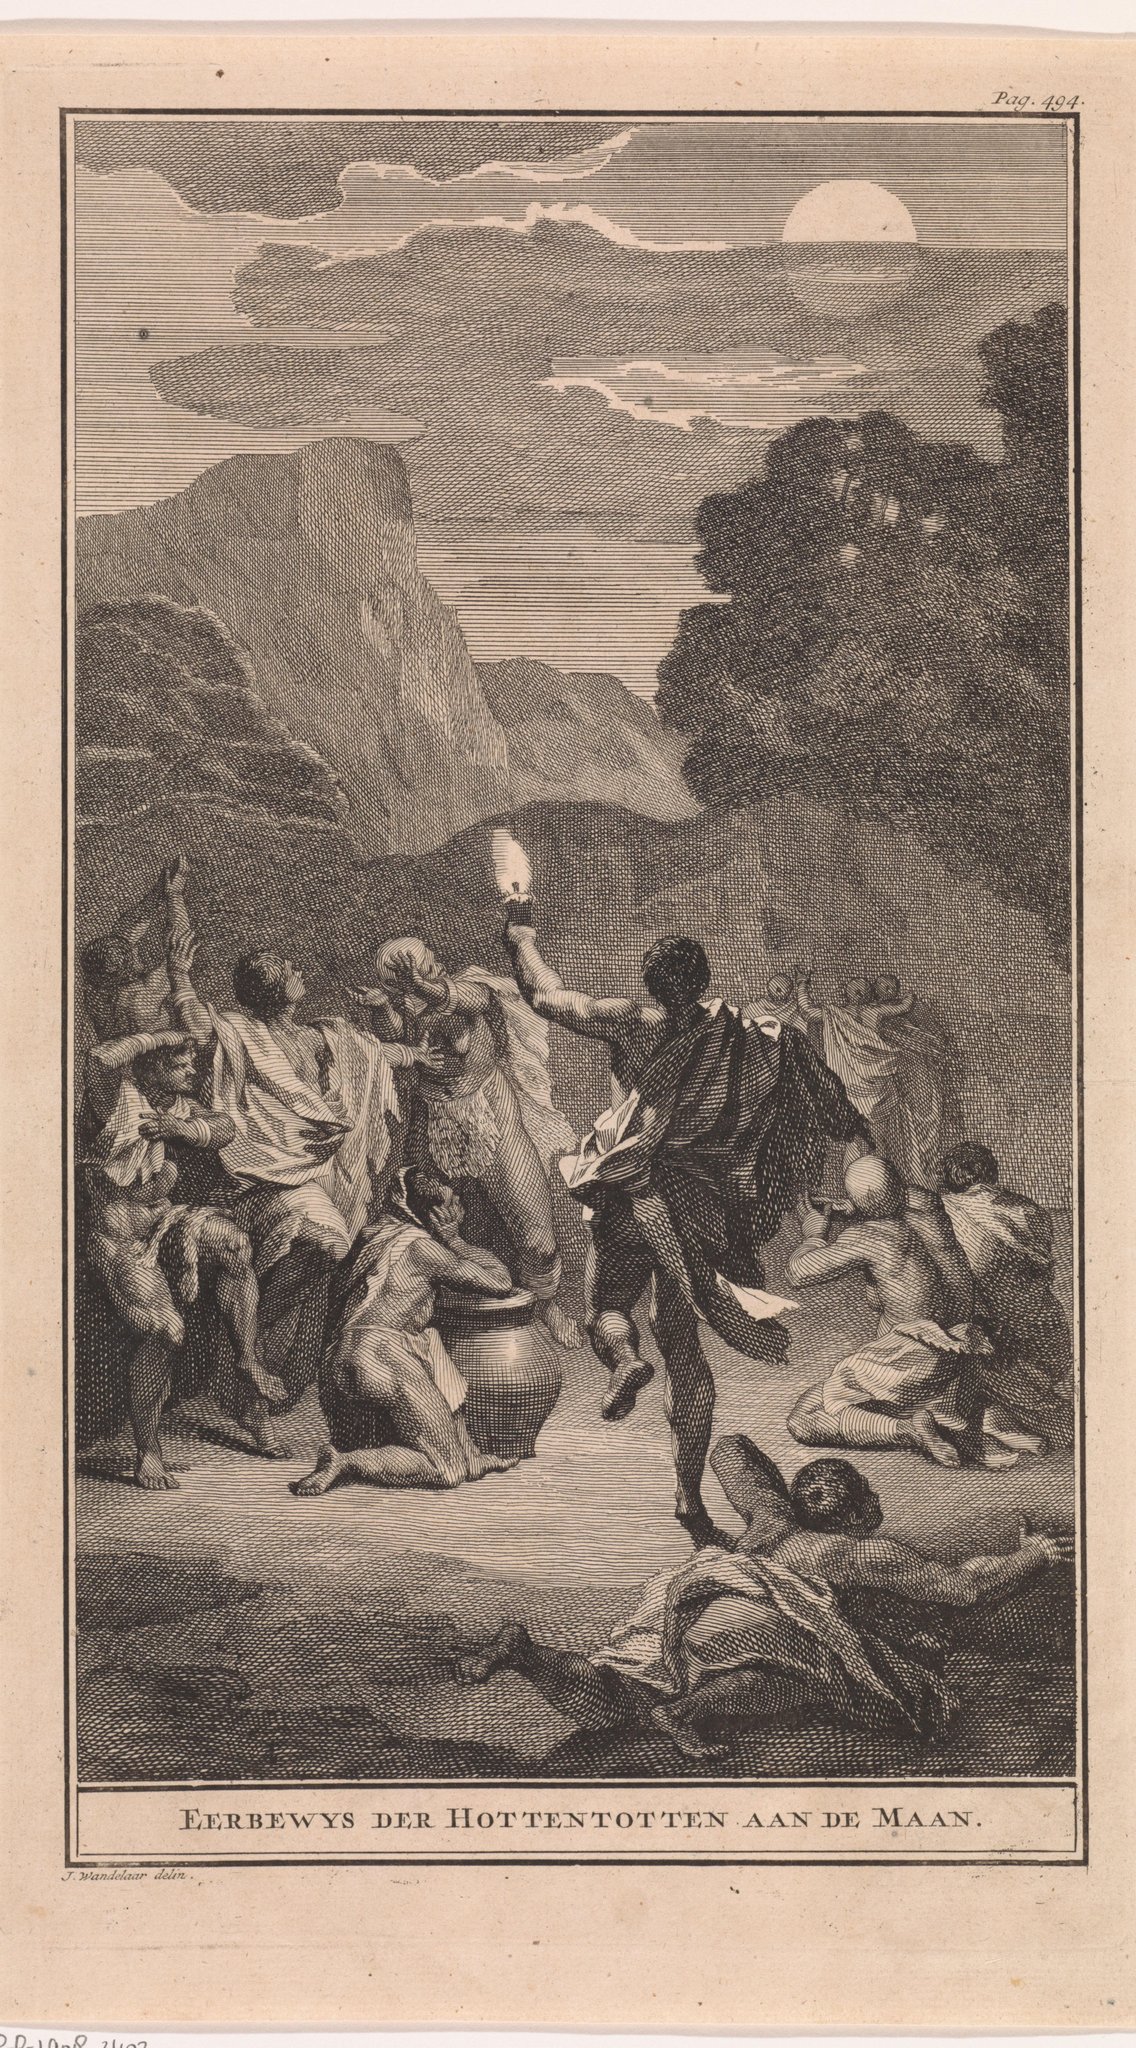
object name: book illustration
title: Eerbewys der Hottentotten aan de Maan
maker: jan wandelaar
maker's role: draughtsman, print maker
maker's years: 1690-1759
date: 1727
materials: paper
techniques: engraving, etching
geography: northern netherlands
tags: full moon, worship and devotion ~ non-christian religions, khoikhoi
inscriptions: collector's mark: Lugt 2228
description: Prent als illustratie gebruikt in: Kolbe, Peter. Naaukeurige en uitvoerige beschryving van de kaap de Goede Hoop; behelzende een zeer omstandig verhaal van den tegenwoordigen toestant van dat vermaarde gewest ... beschryving van de oorsprong der Hottentotten, deel I, p. 494. Amsterdam: Balthazar Lakeman, 1727.